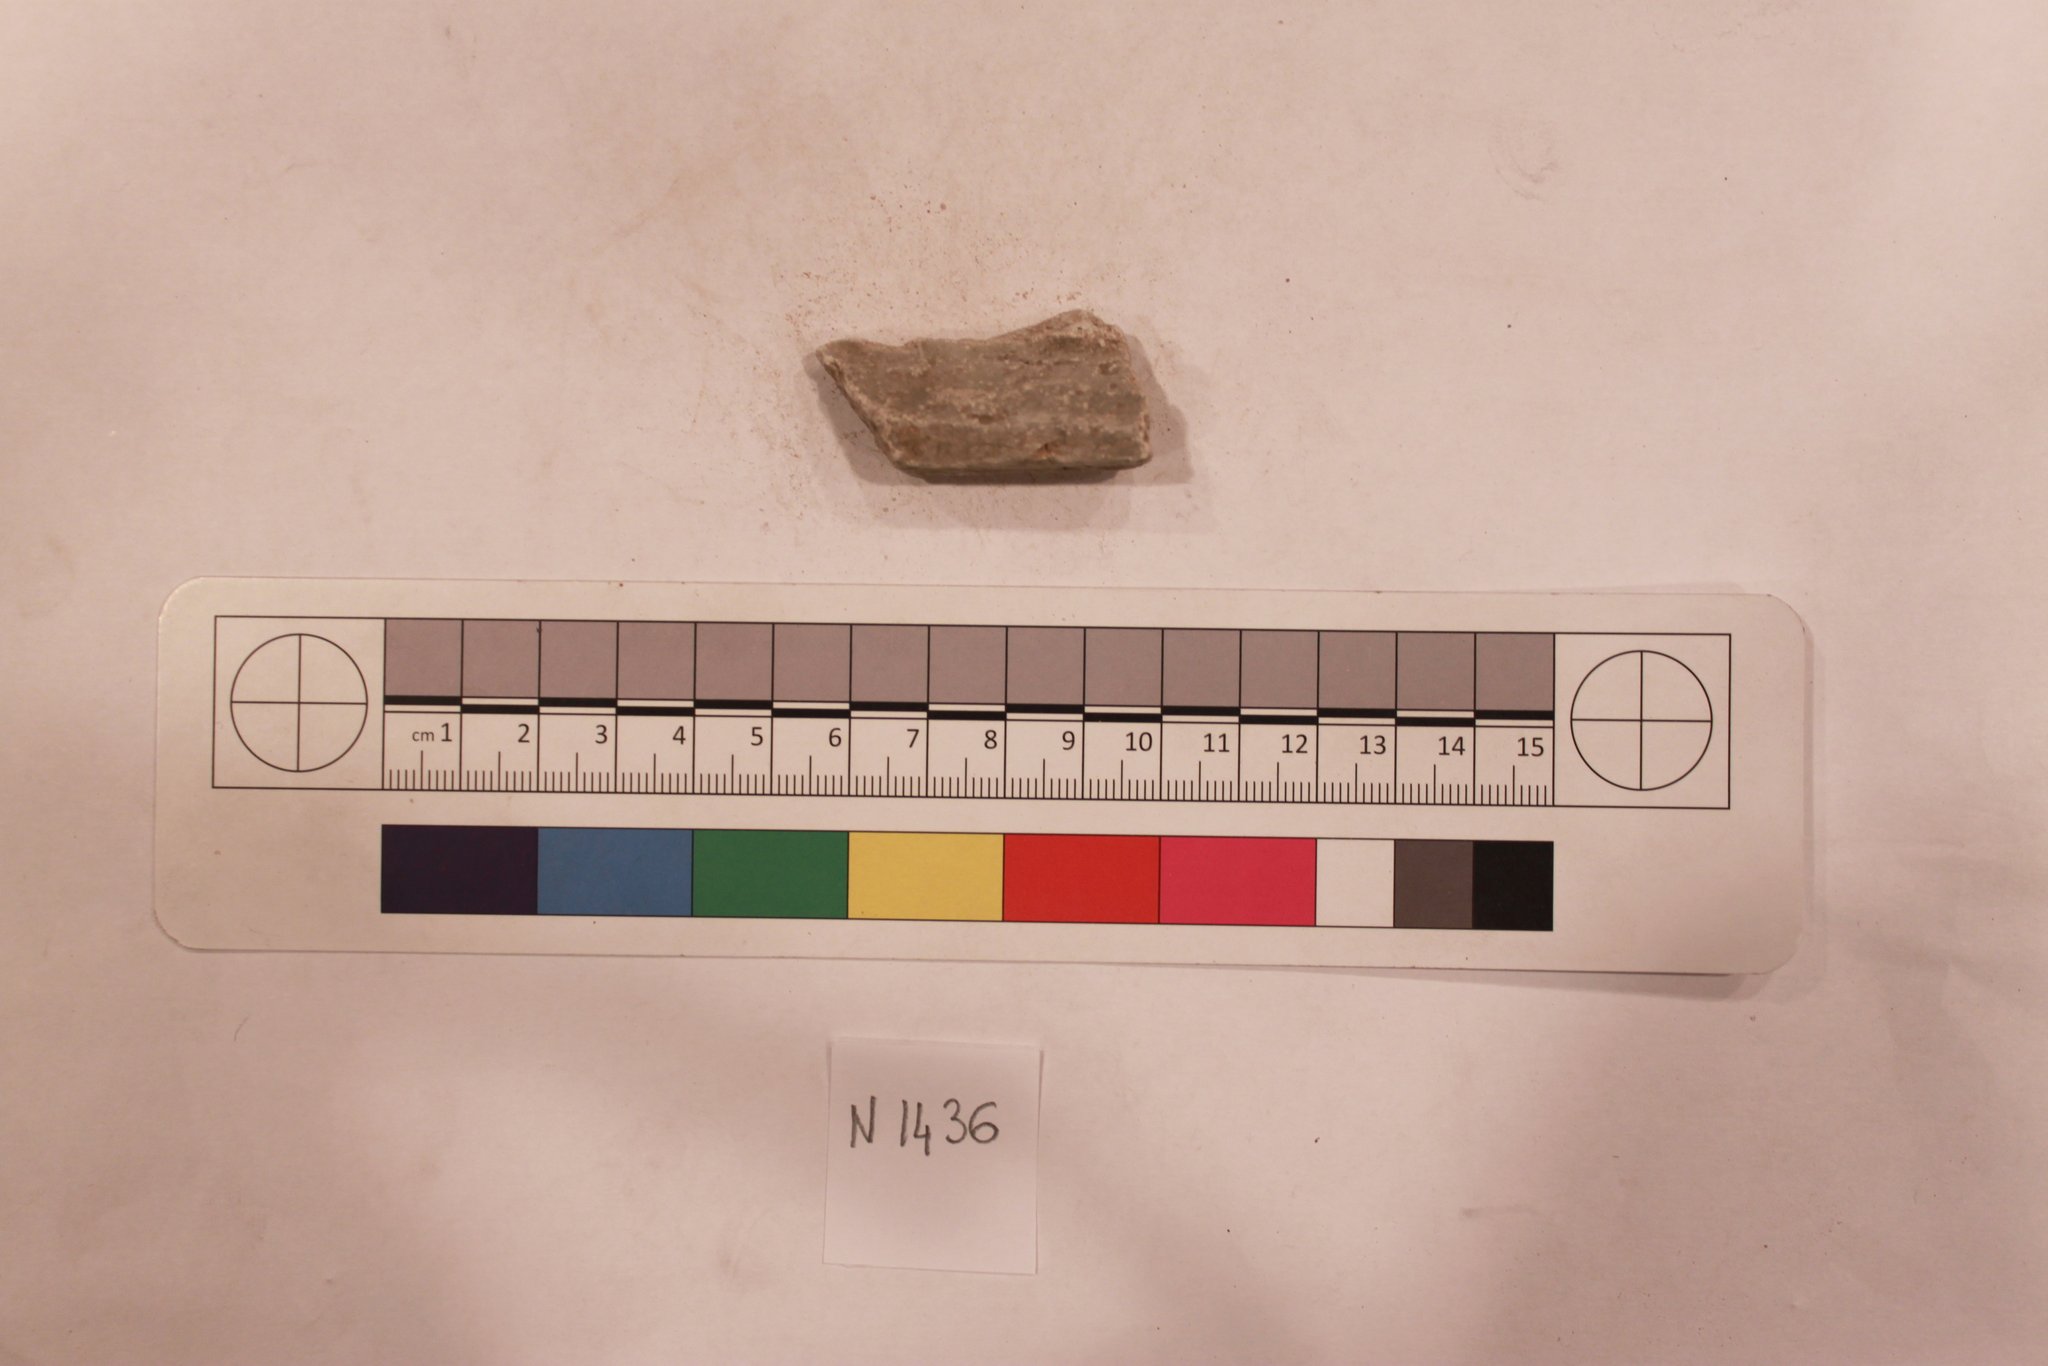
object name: fragment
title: Stucco Fragment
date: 701-1200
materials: plaster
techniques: carving, painting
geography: iran